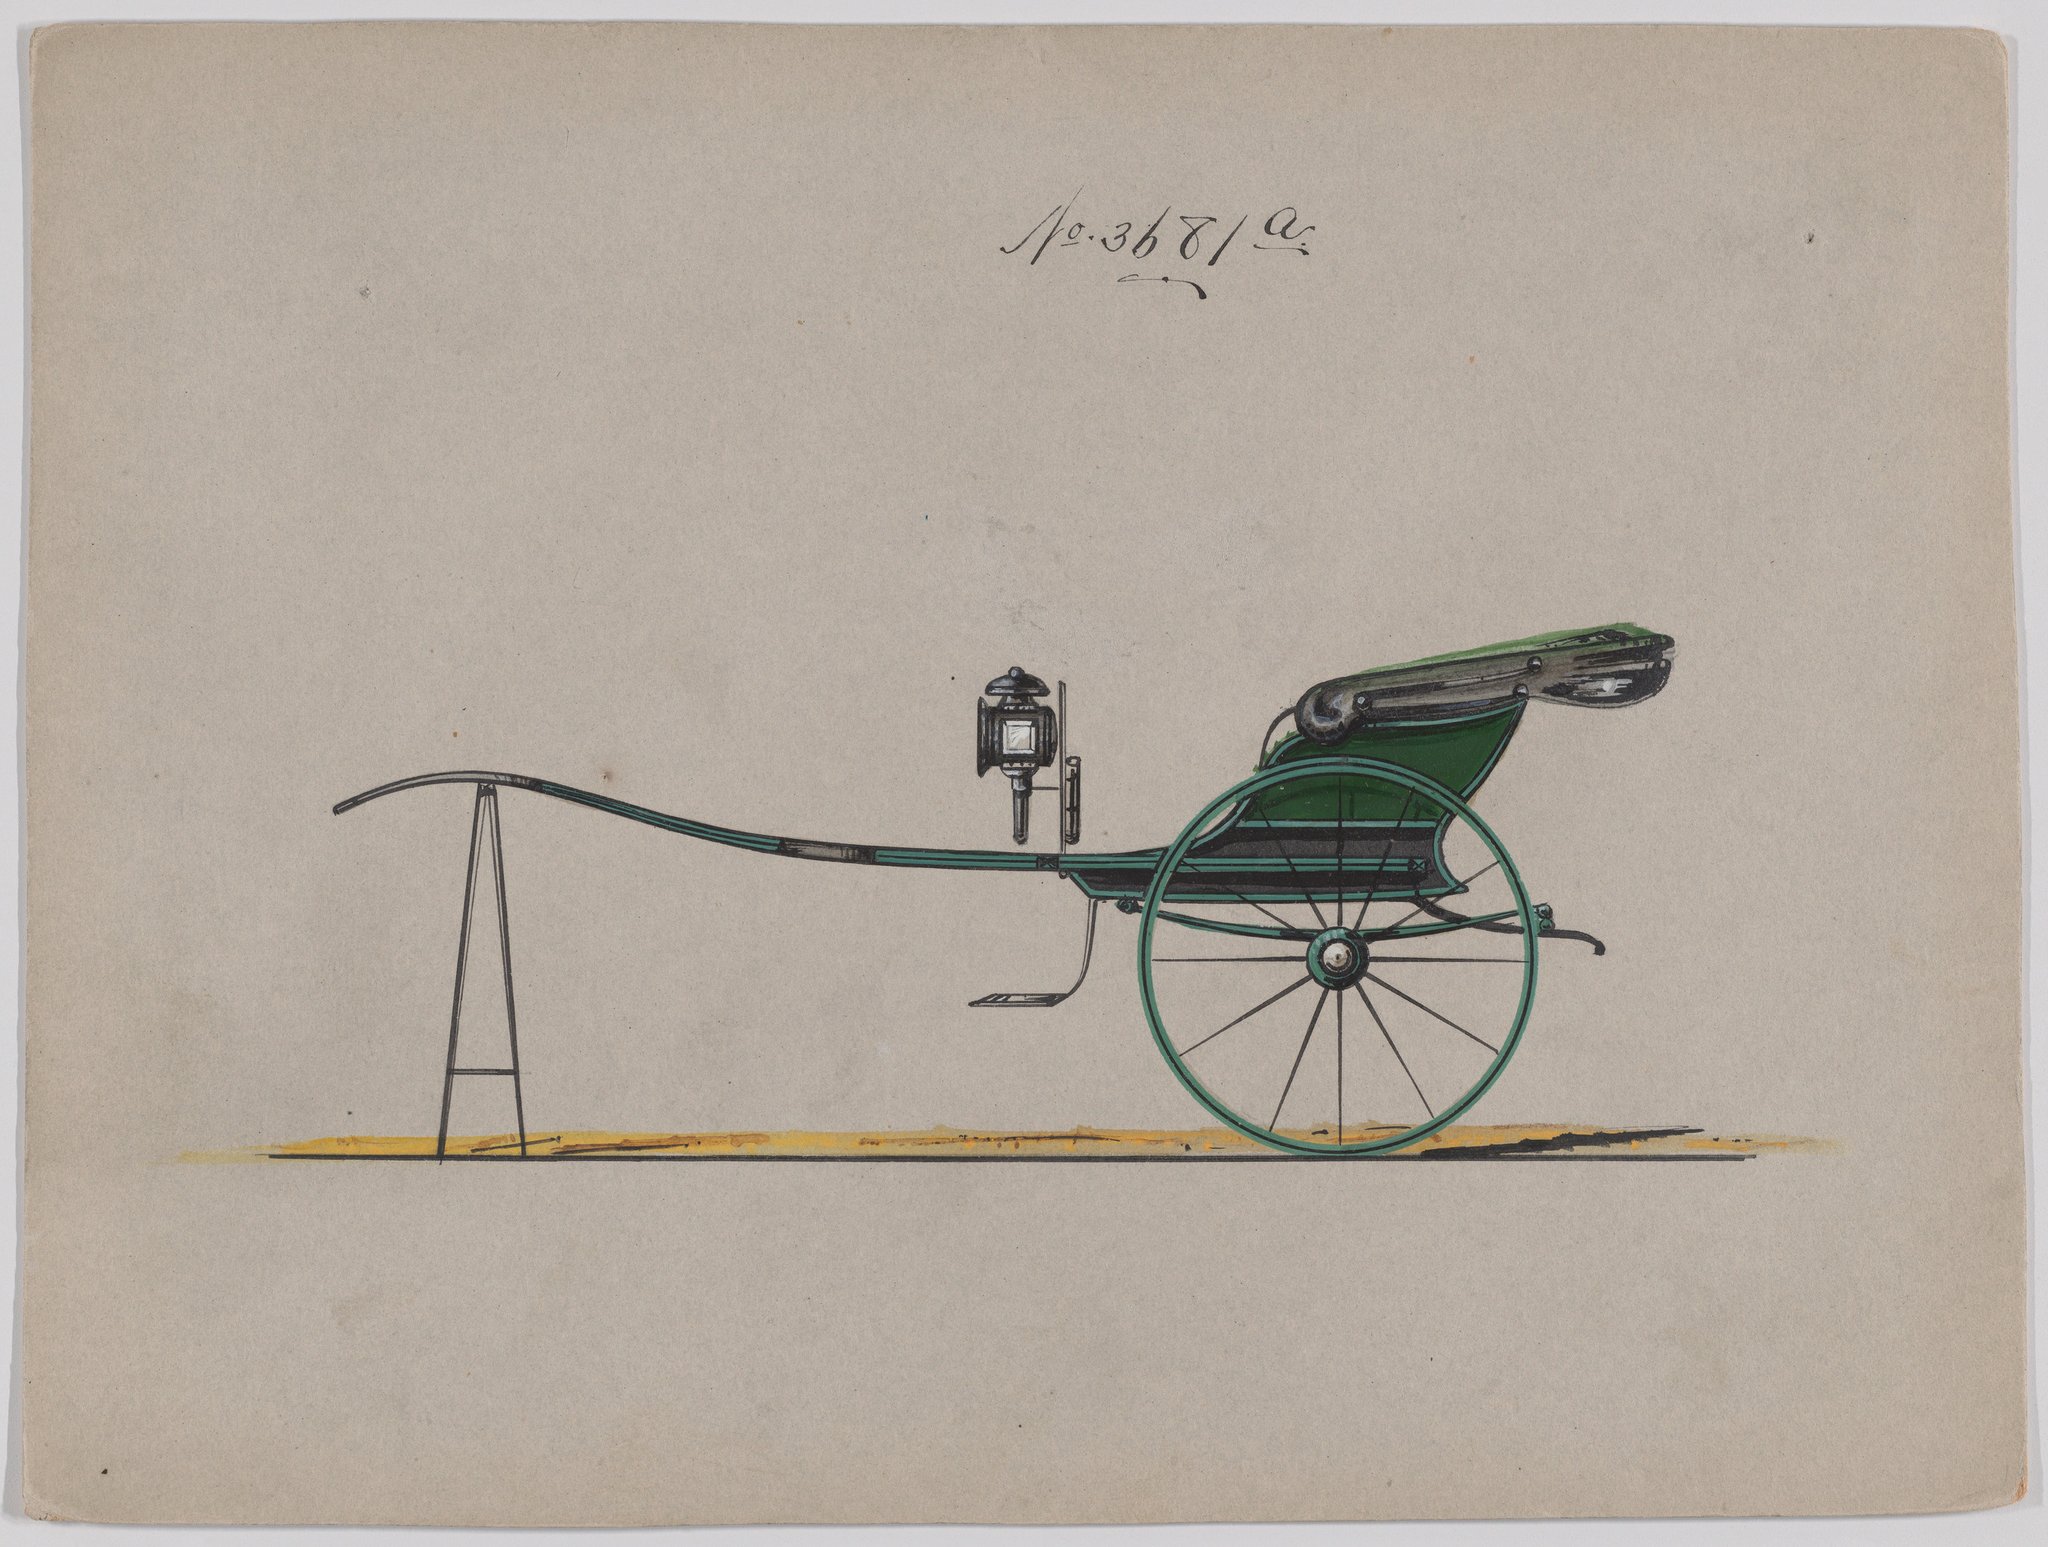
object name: drawing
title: Gig #3681a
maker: brewster & co.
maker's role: manufacturer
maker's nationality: american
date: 1881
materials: ink, watercolor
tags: carriages